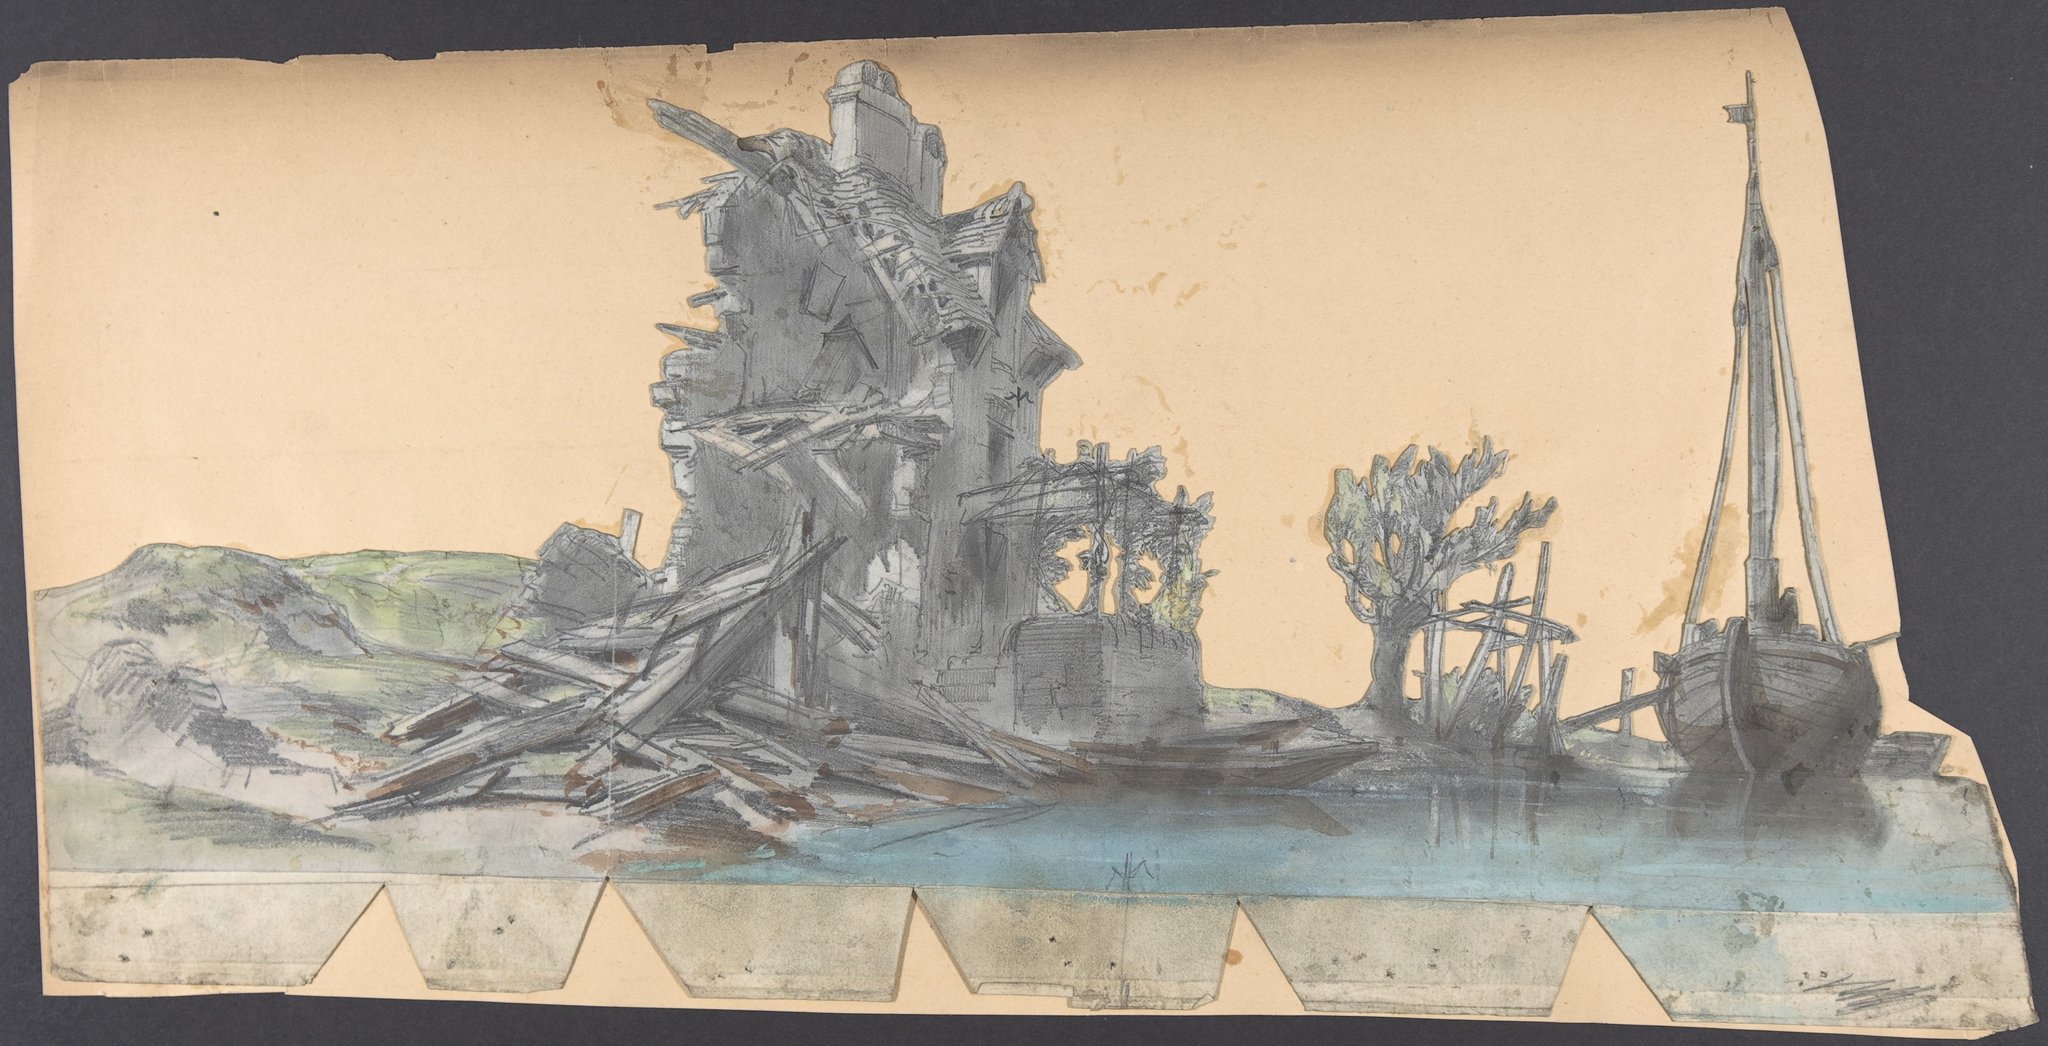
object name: drawing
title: Design for a Stage Set at the Opéra, Paris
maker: eugène cicéri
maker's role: artist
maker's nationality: french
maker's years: 1813-1890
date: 1830-1890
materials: graphite, watercolor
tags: ruins,boats,stage design